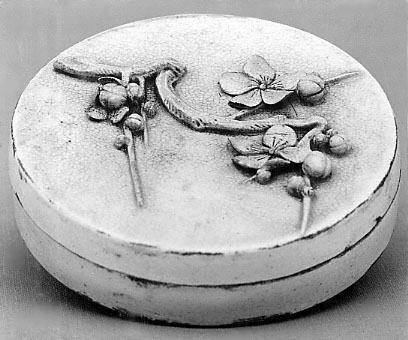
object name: incense box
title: Covered Box for Incense with Molded Blossoming Plum Branch Design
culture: japanese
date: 1800-1850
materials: glaze, pottery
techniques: molding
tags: flowers